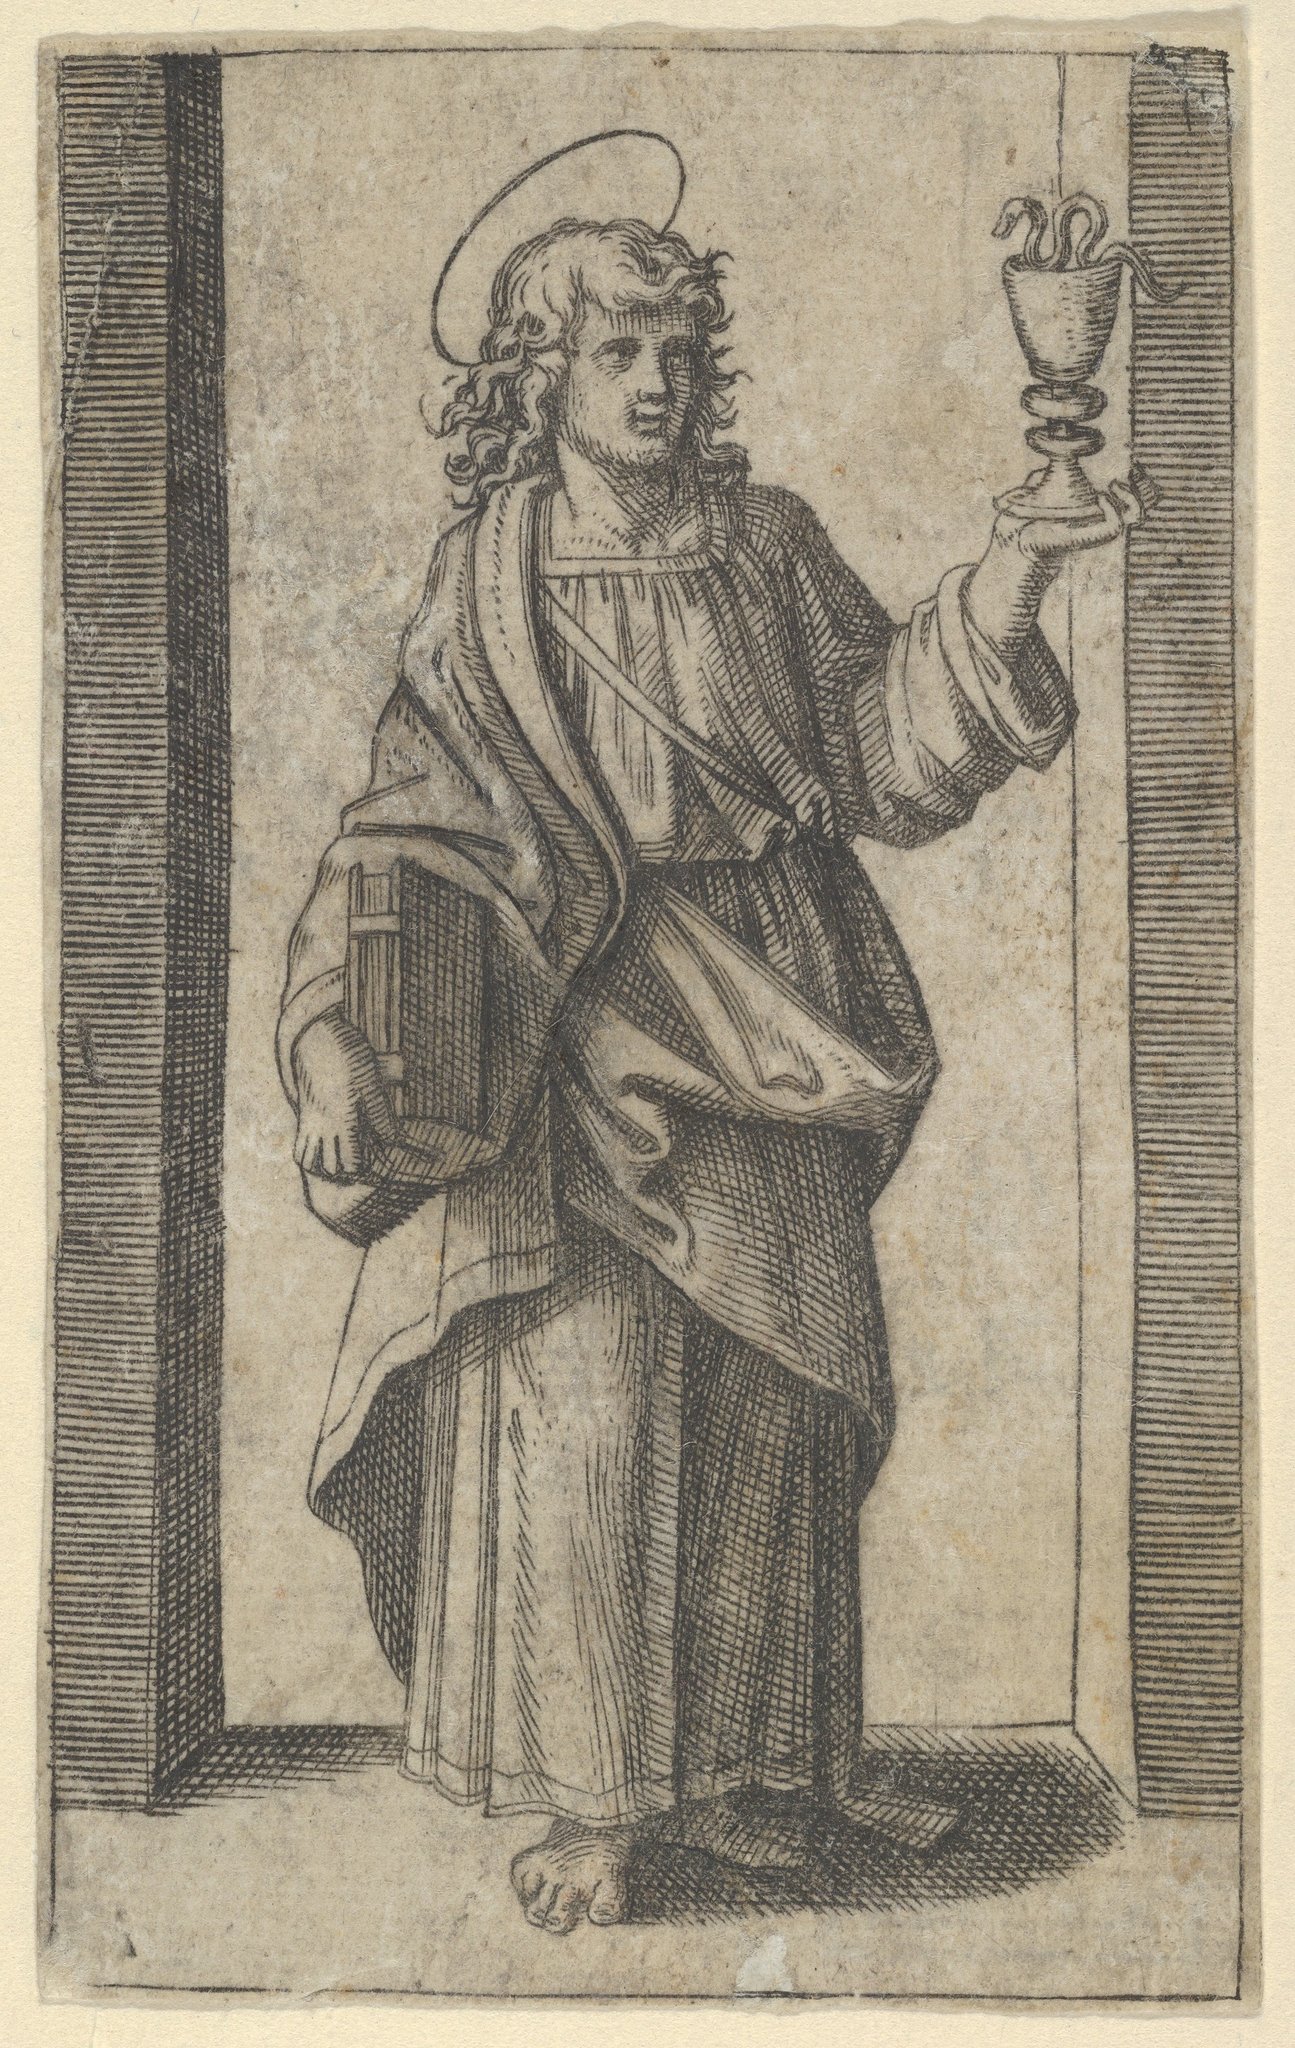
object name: print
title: Saint John, book in right hand chalice in left, from "Piccoli Santi" (Small Saints)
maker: marcantonio raimondi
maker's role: artist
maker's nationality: italian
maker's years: 1475-1534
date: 1500-1527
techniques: engraving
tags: books,saint john the baptist,chalices